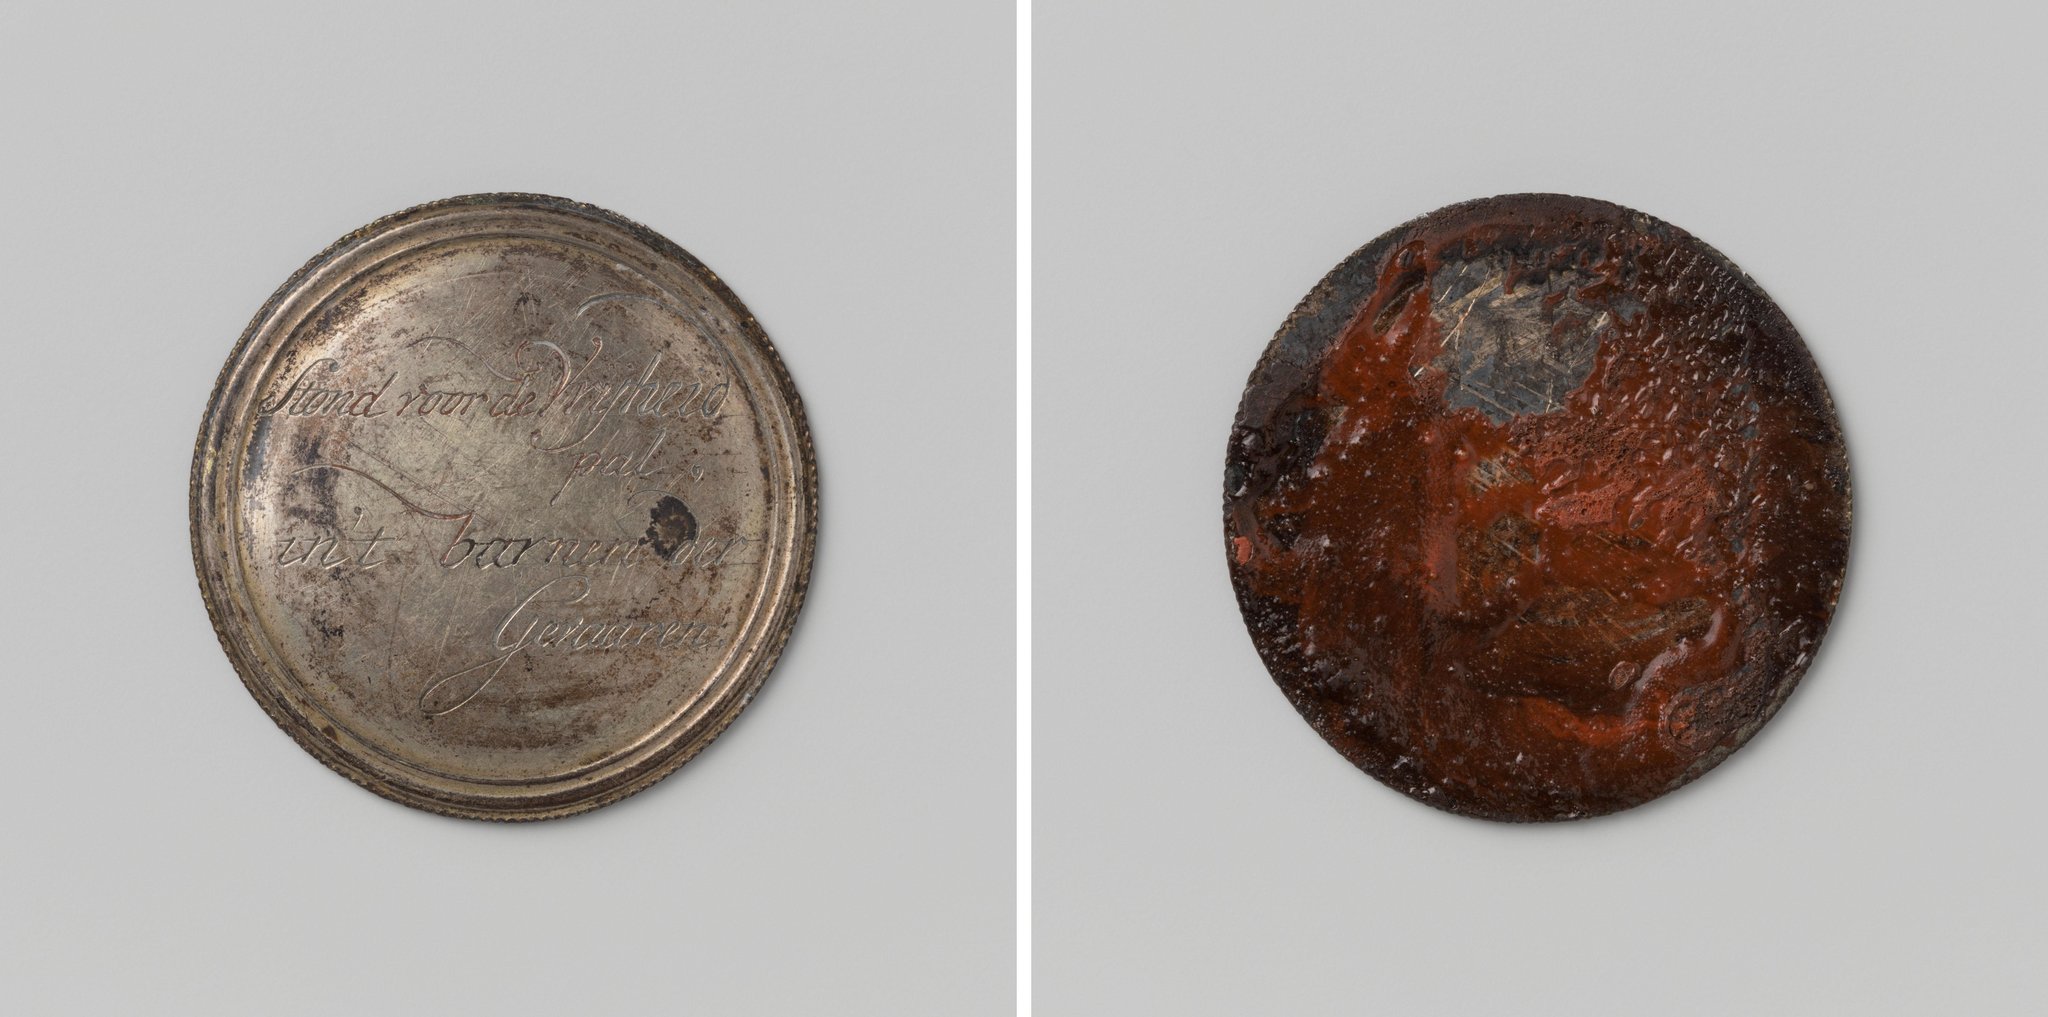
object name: plate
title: Plaatje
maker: Anonymous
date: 1700-1800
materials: silver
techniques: engraving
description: Eenzijdig plaatje. Voorzijde: opschrift: "Stond voor de Vrijheid pal in't barnen der Gevaaren". Keerzijde: blanco. Vermoedleijk een zijde van een penning.